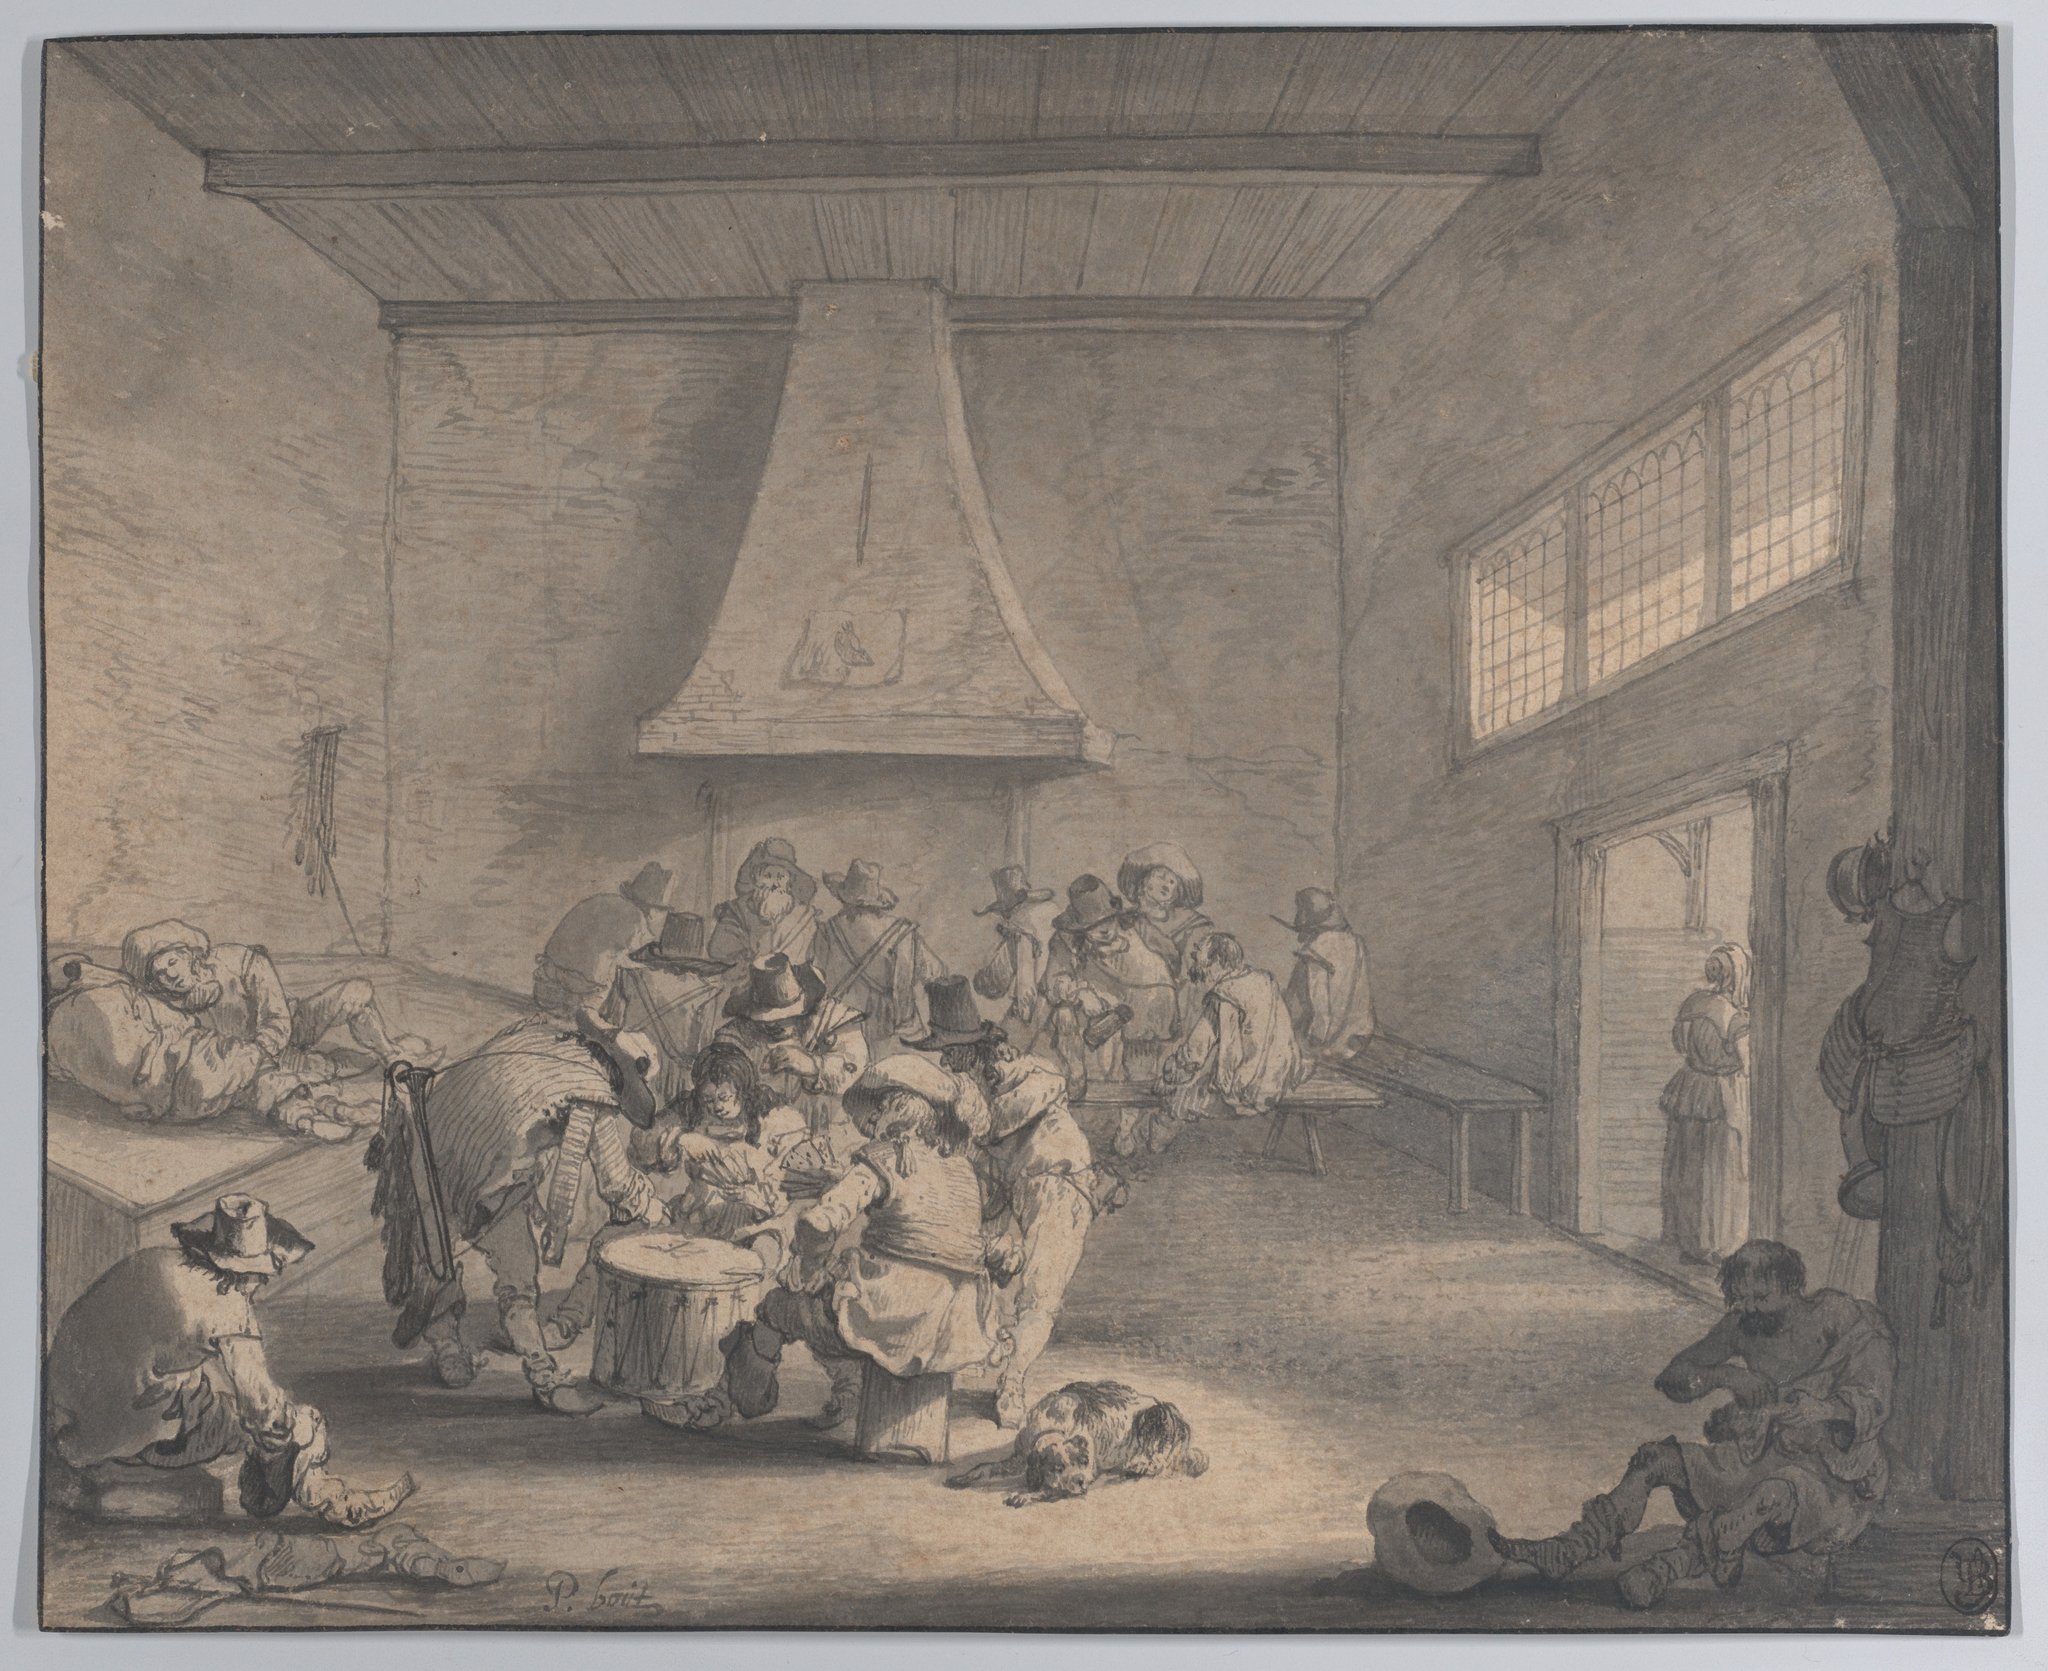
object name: drawing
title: Guardroom Scene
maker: pieter bout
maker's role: artist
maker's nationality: flemish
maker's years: 1658-1719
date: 1700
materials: ink, paper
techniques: brush, pen, wash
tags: soldiers,men,drums,dogs